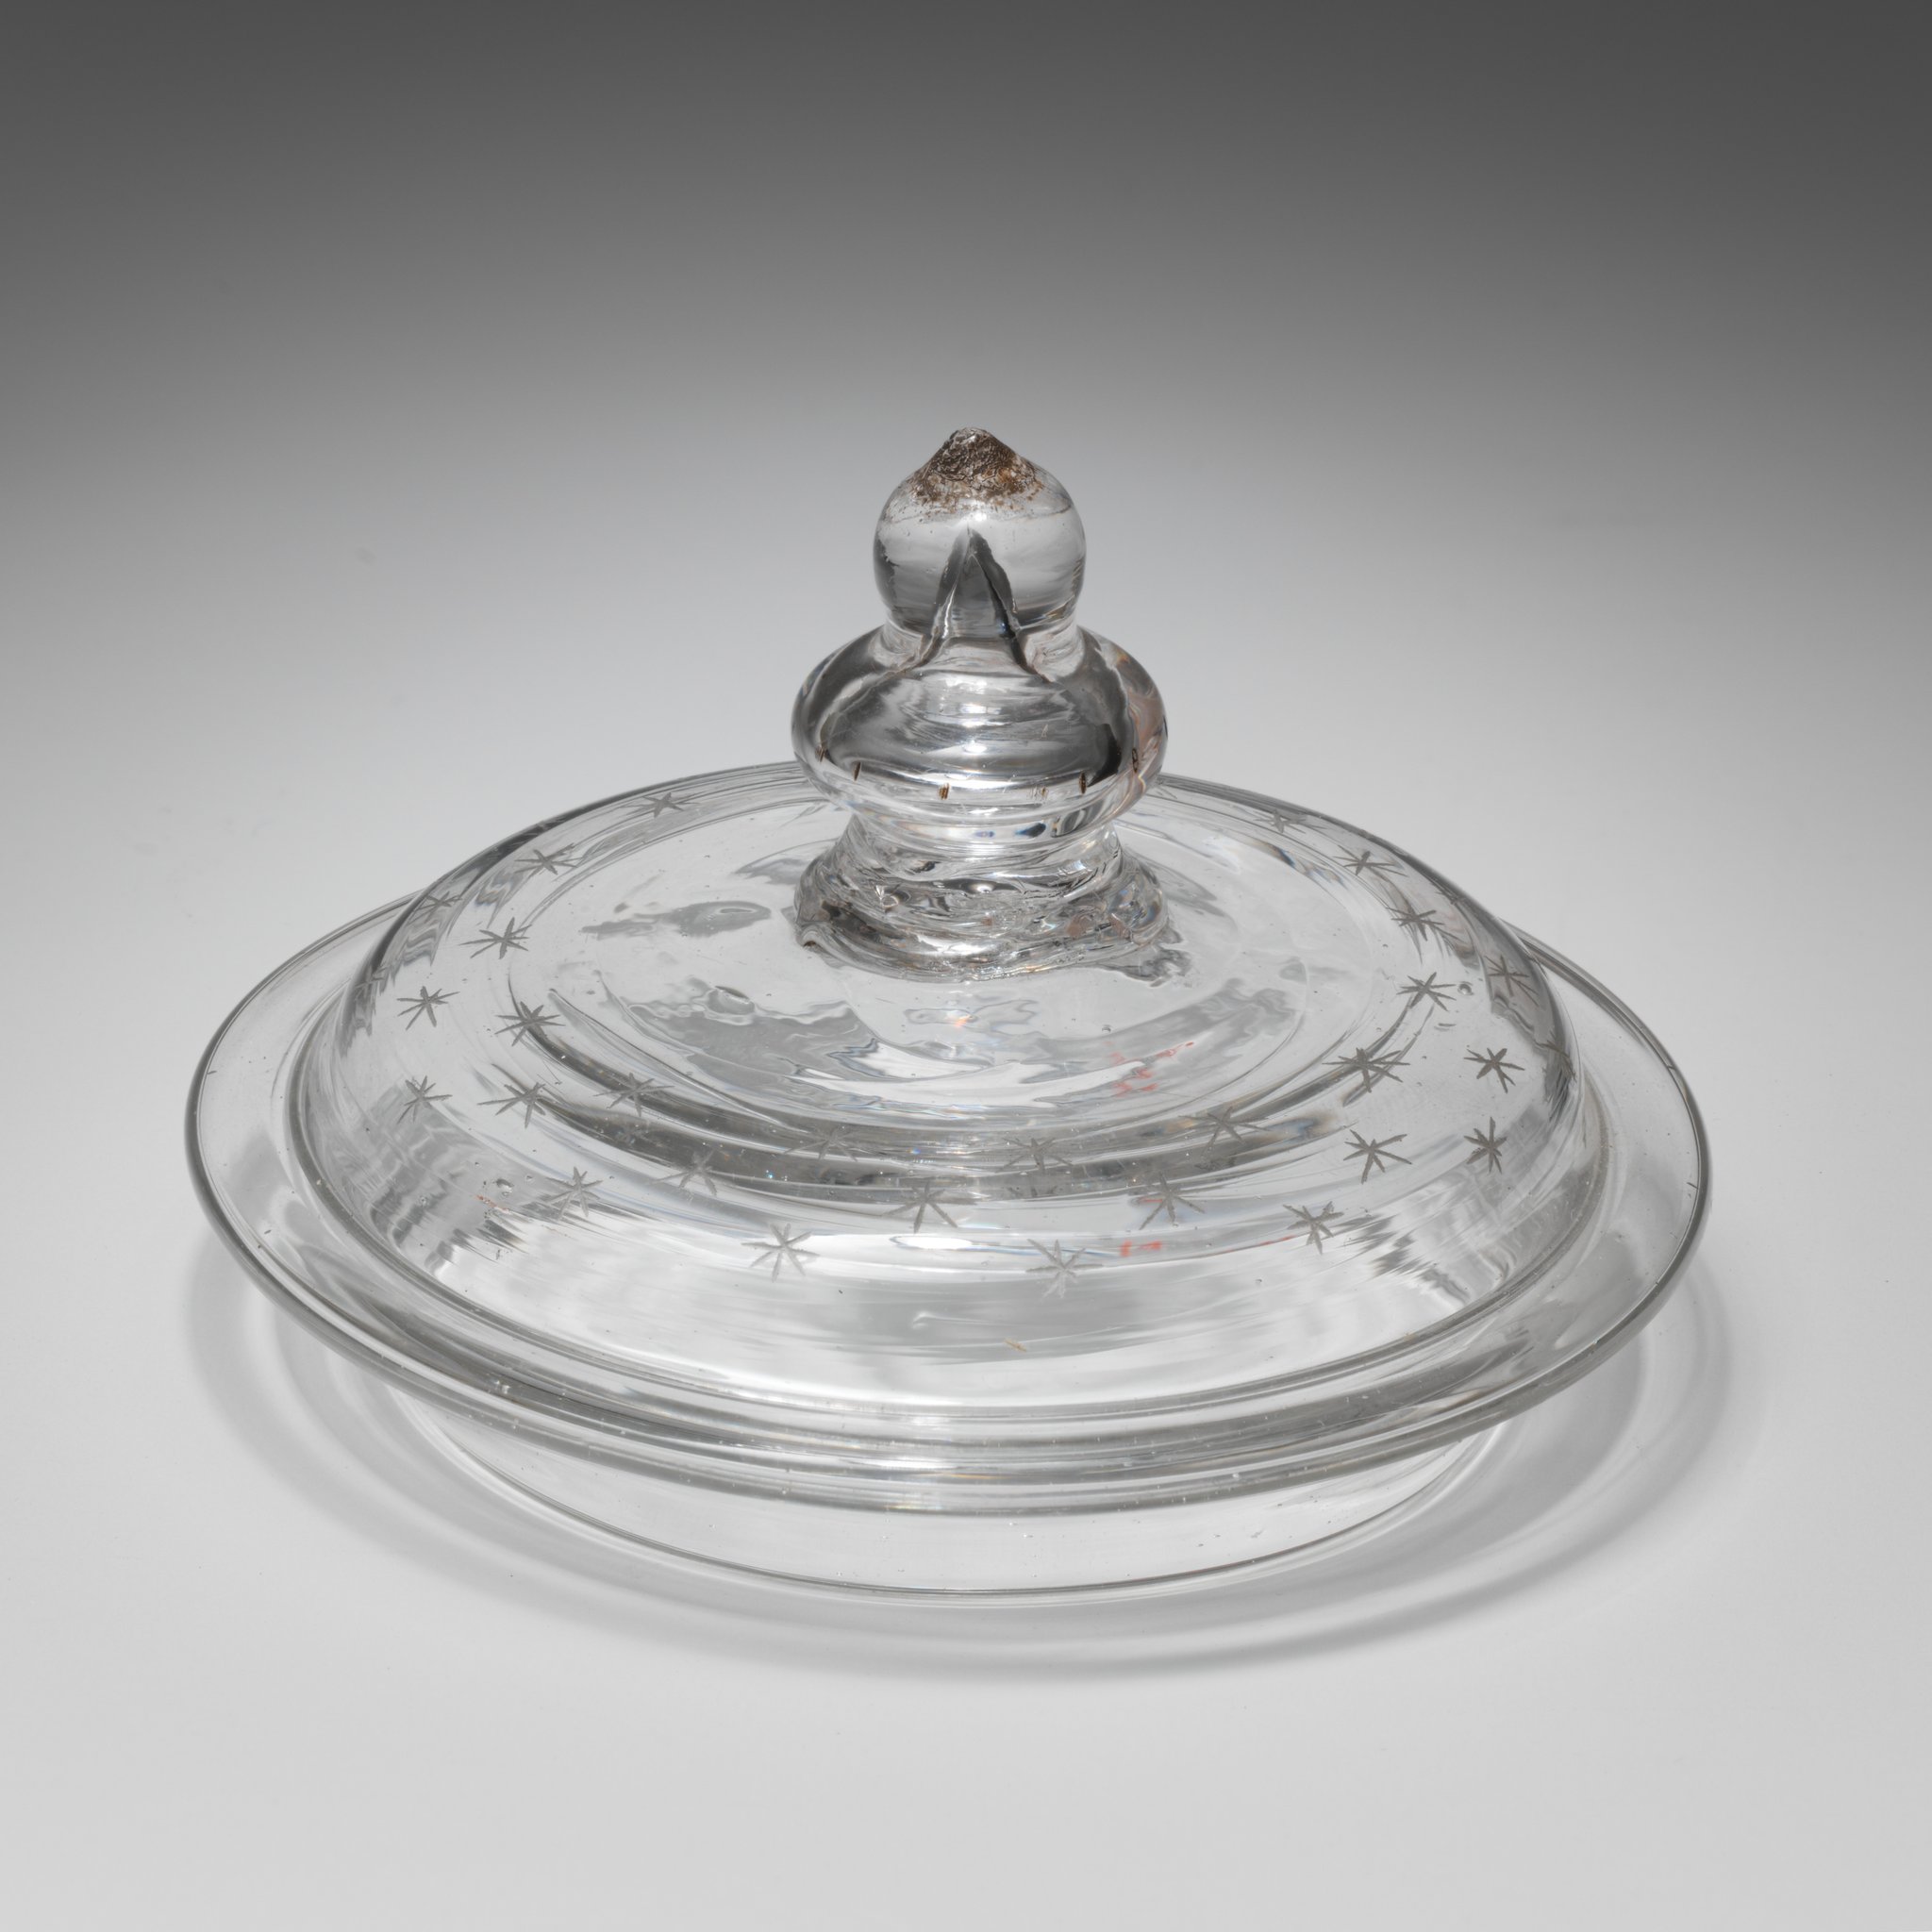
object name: cover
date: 1701-1800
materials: glass